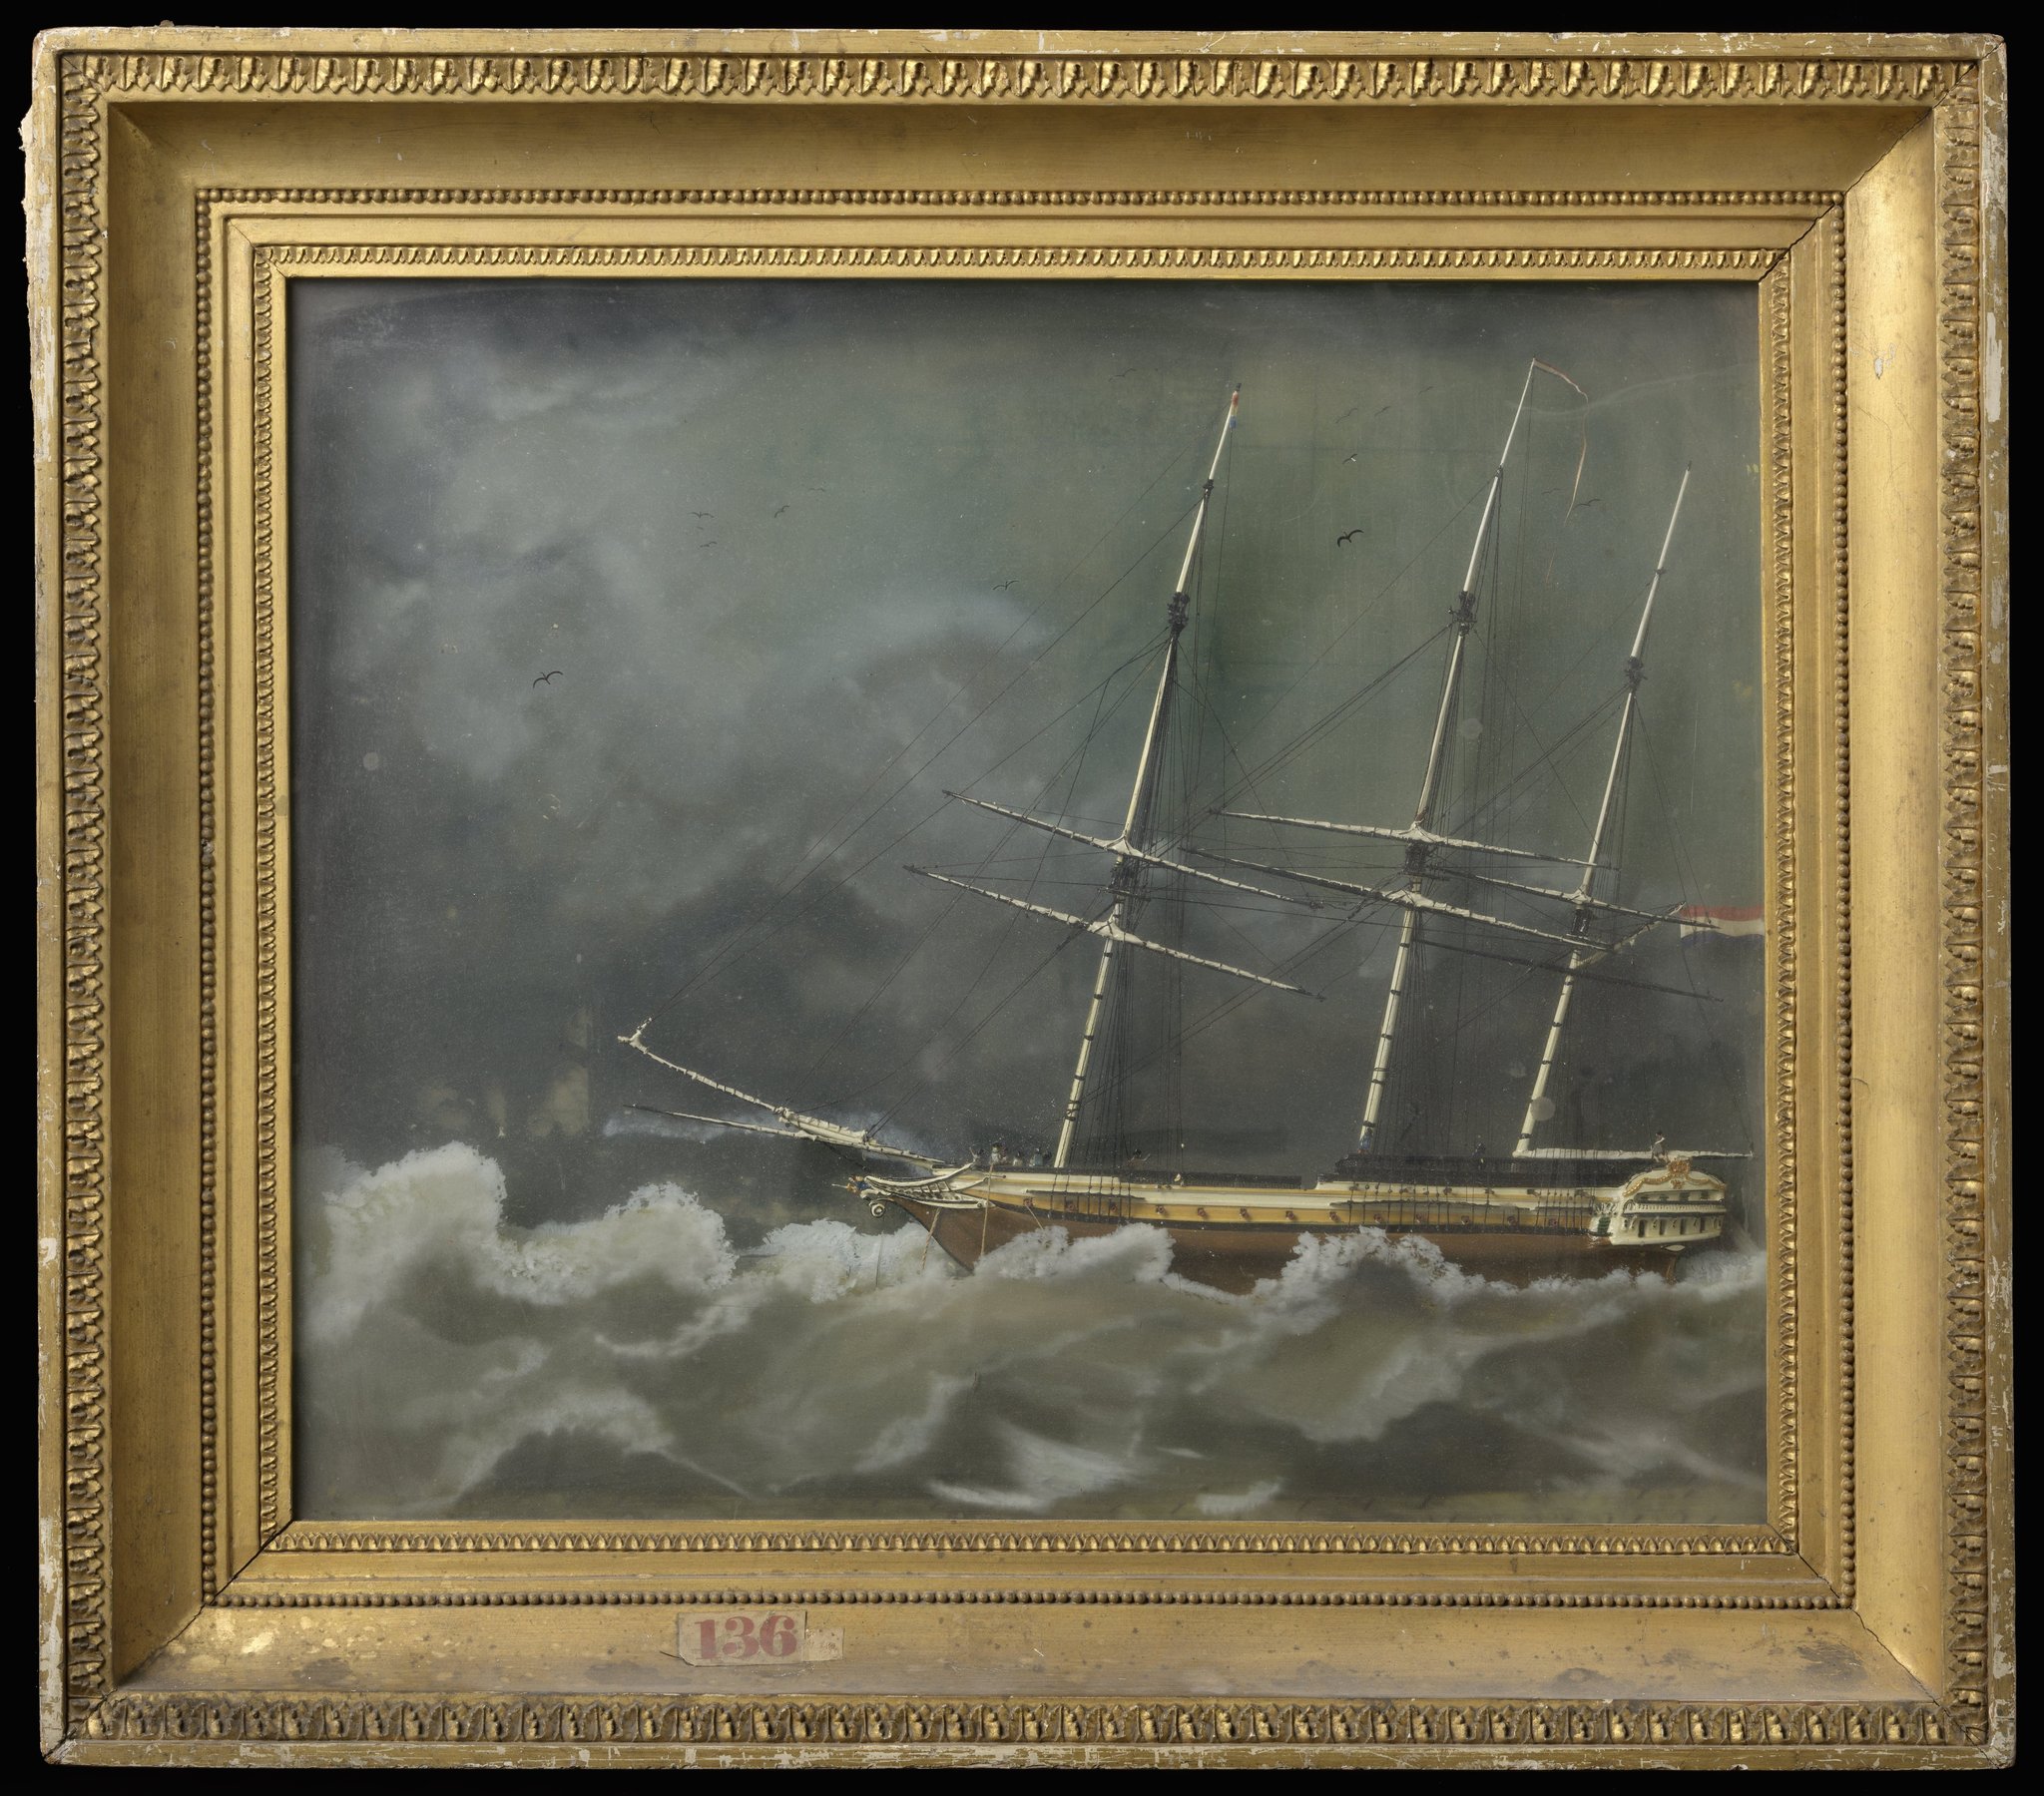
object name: ship model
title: Ship Diorama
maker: Anonymous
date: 1815-1875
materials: glass, metal, paint, paper, fiber, wood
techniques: polychromy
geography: netherlands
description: Driedimensionale voorstelling in verdiepte schilderijlijst, een zgn. scheepje-in-de-kast of scheepsdiorama. Nachtelijke scène van een zeilschip in een onstuimige zee met golven met witte schuimkoppen en omringd door enkele meeuwen. De getuigde driemaster van 40 stukken, varend van rechts naar links, voert de Nederlandse vlag. Alle zeilen van het schip zijn gereefd. Aan boord zijn tien bemanningsleden te zien. Het schegbeeld is een man in een blauw uniform met een sabel in de rechterhand. Op de achtersteven een galerij en op het hek een gekroonde W als monogram. Het geheel in houten lijst met sierrand.